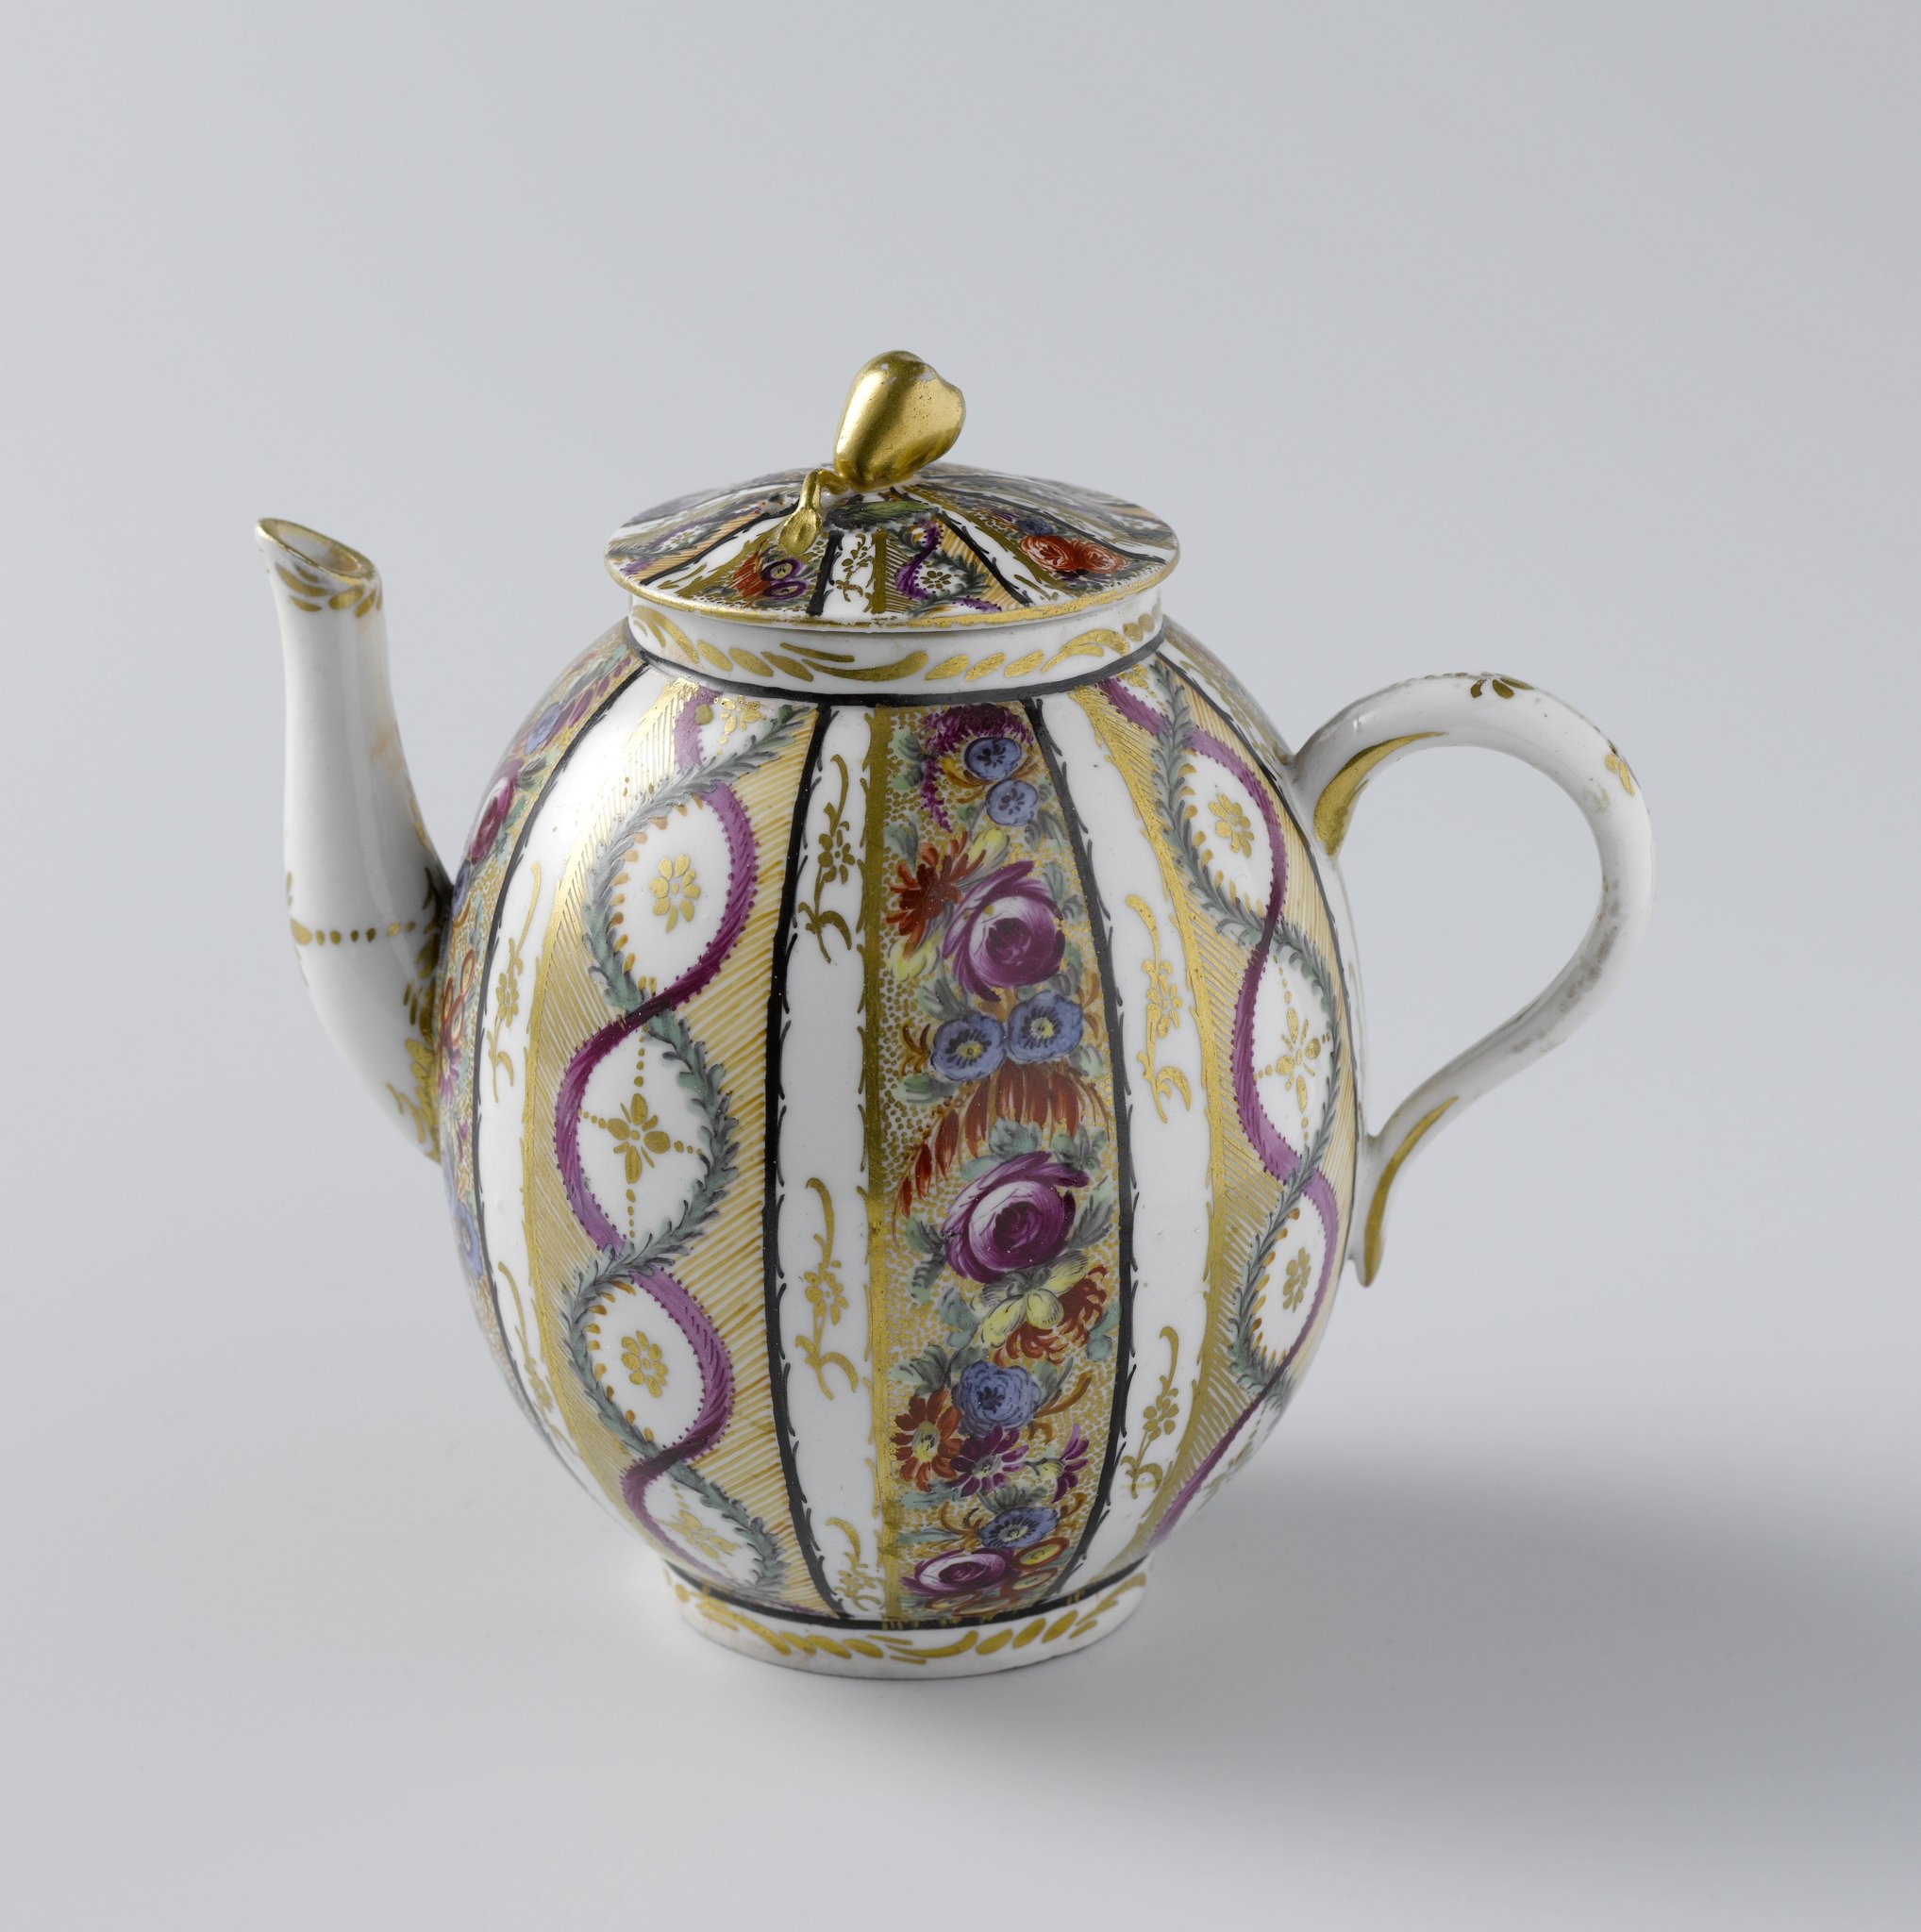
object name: tête à tête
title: Teapot with vertical borders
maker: louis victor gerverot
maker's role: ceramicist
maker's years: 1747-1829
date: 1773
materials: glaze, gold, paint, porcelain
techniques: firing, forming, gilding, vitrification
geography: höchst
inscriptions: mark: ‘M/ g’, mark: ‘IP’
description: Theepot van porselein met een ovaal lichaam, gebogen tuit en C-vormig oor, beschilderd op het glazuur in blauw, rood, roze, groen, geel, zwart en goud. De buik is verdeeld in verticale banden afwisselend gevuld met bloemranken, elkaar snijdende bladranken waarbinnen een rozet en smalle banden met gouden bloemtakken. De nek en de voet met een bladrank. Op het oor en de tuit stippen en een bloemmotief. De deksel met dezelfde decoratie; dekselknop in de vorm van een fruittak (peer). Gemerkt op de onderzijde met IP, een schild met M en een g.